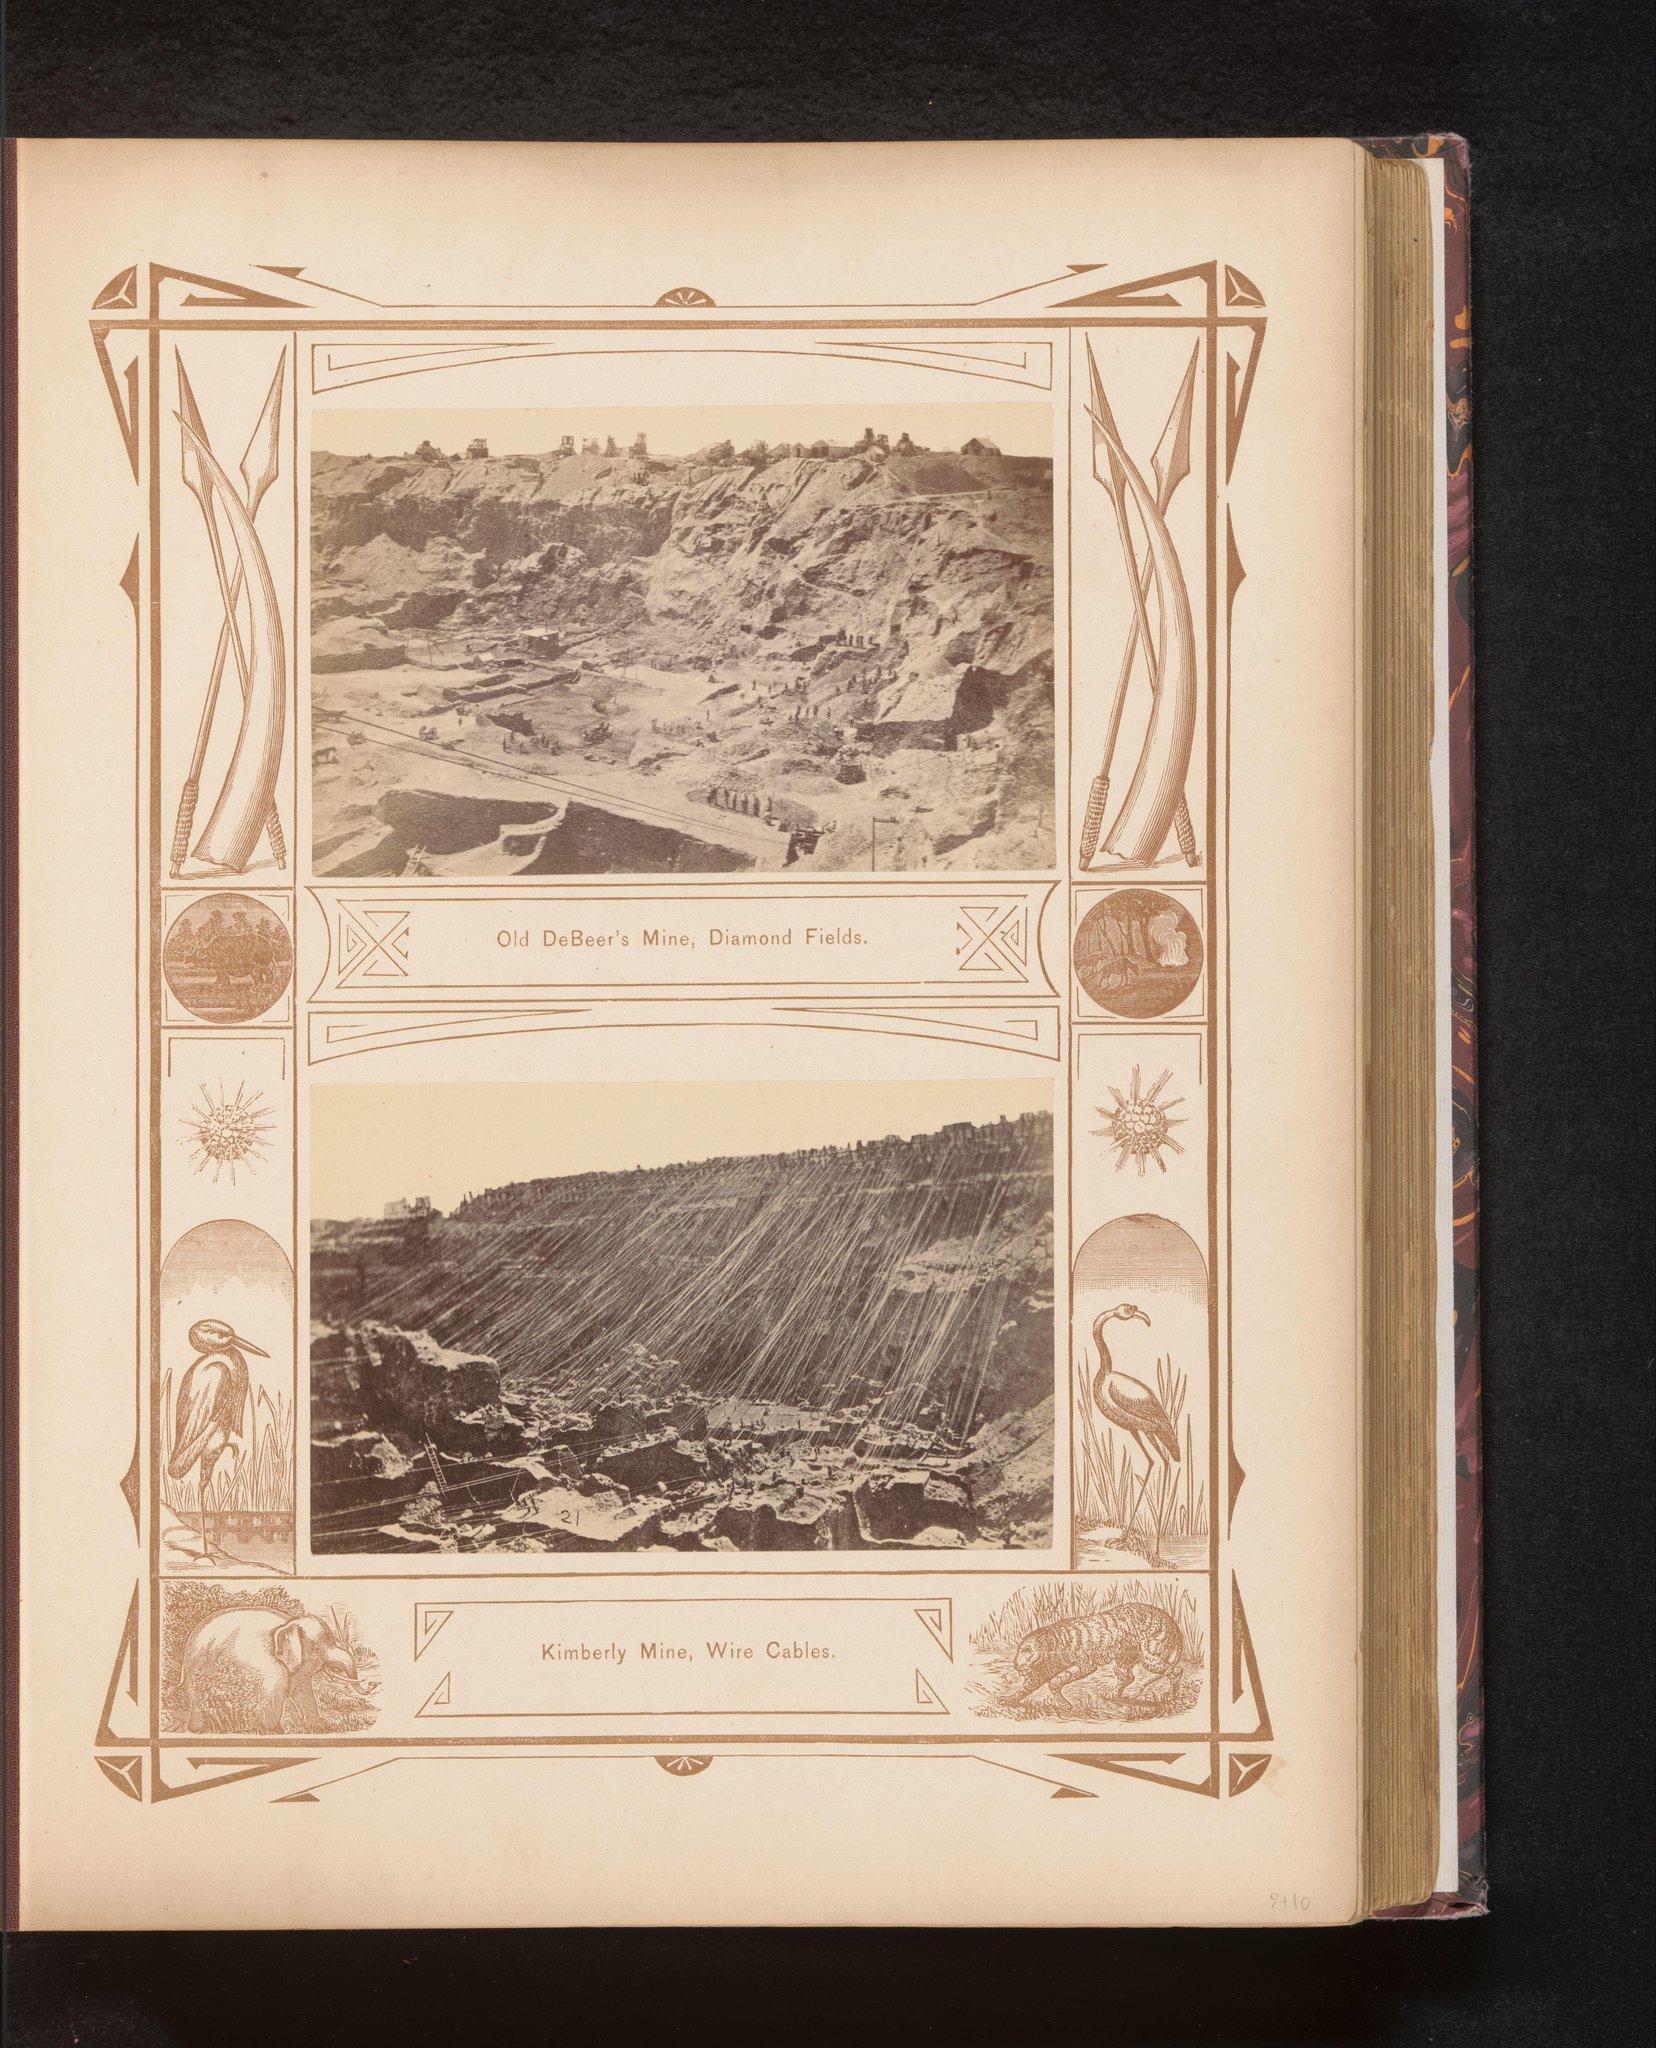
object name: page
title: Gezicht op De Beers mijn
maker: Anonymous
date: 1877-1882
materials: photographic support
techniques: albumen print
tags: mine